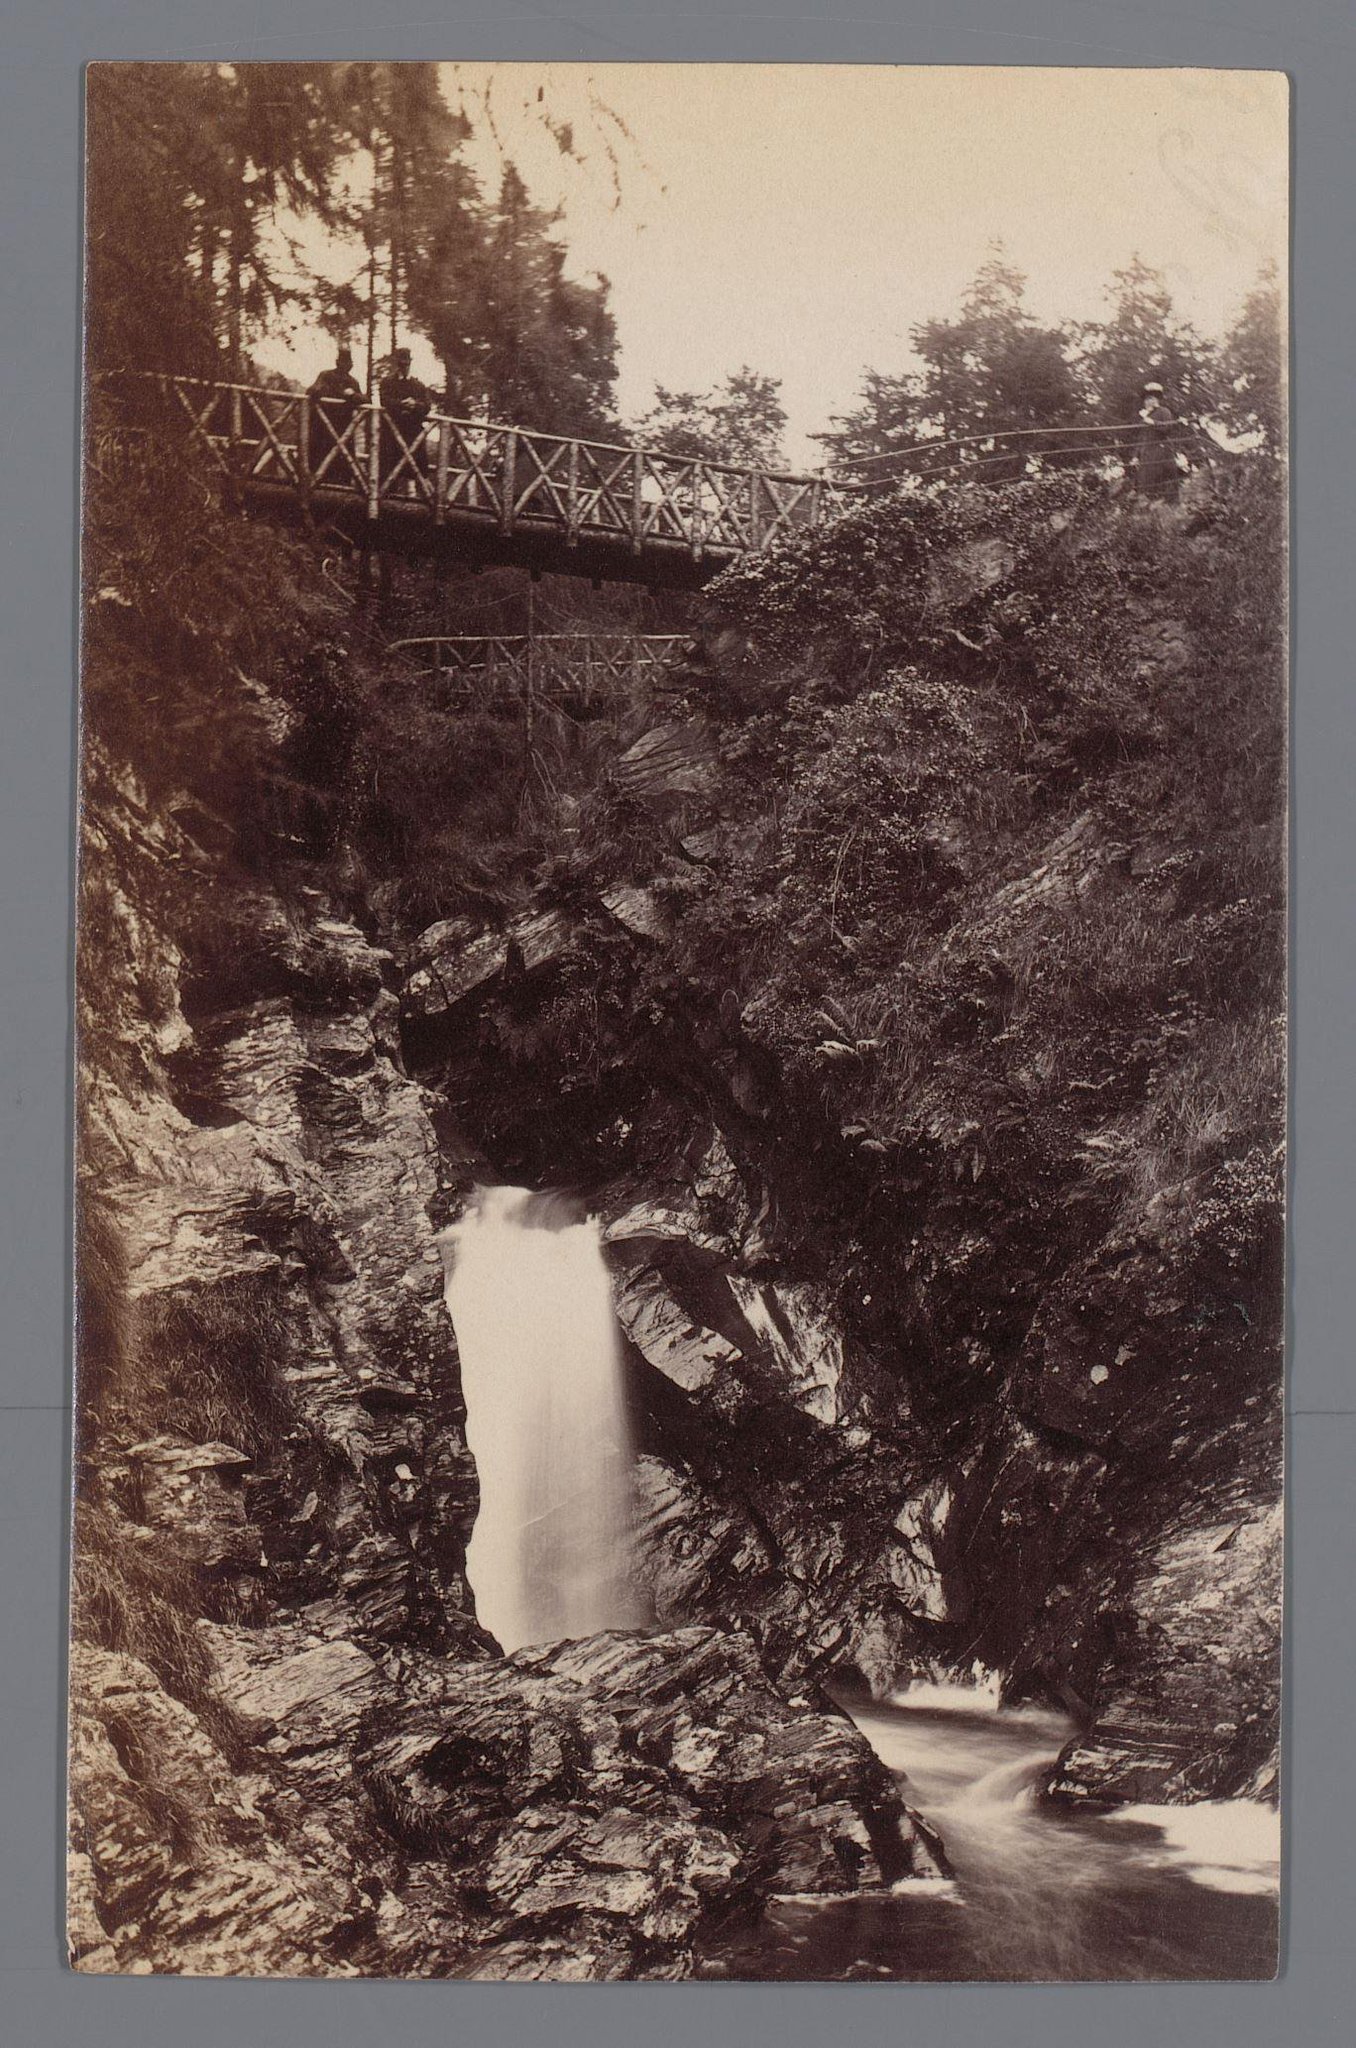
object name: photograph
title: Glen Helen, Isle of Man, Verenigd Koninkrijk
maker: Anonymous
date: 1875-1890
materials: photographic support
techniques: albumen print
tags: great britain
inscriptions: stamp: ‘B J P Rivero [?] No. 74’, caption: ‘Glen Helen’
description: Waterval en bossen. Boven de waterval staan twee mannen op een houten brug.